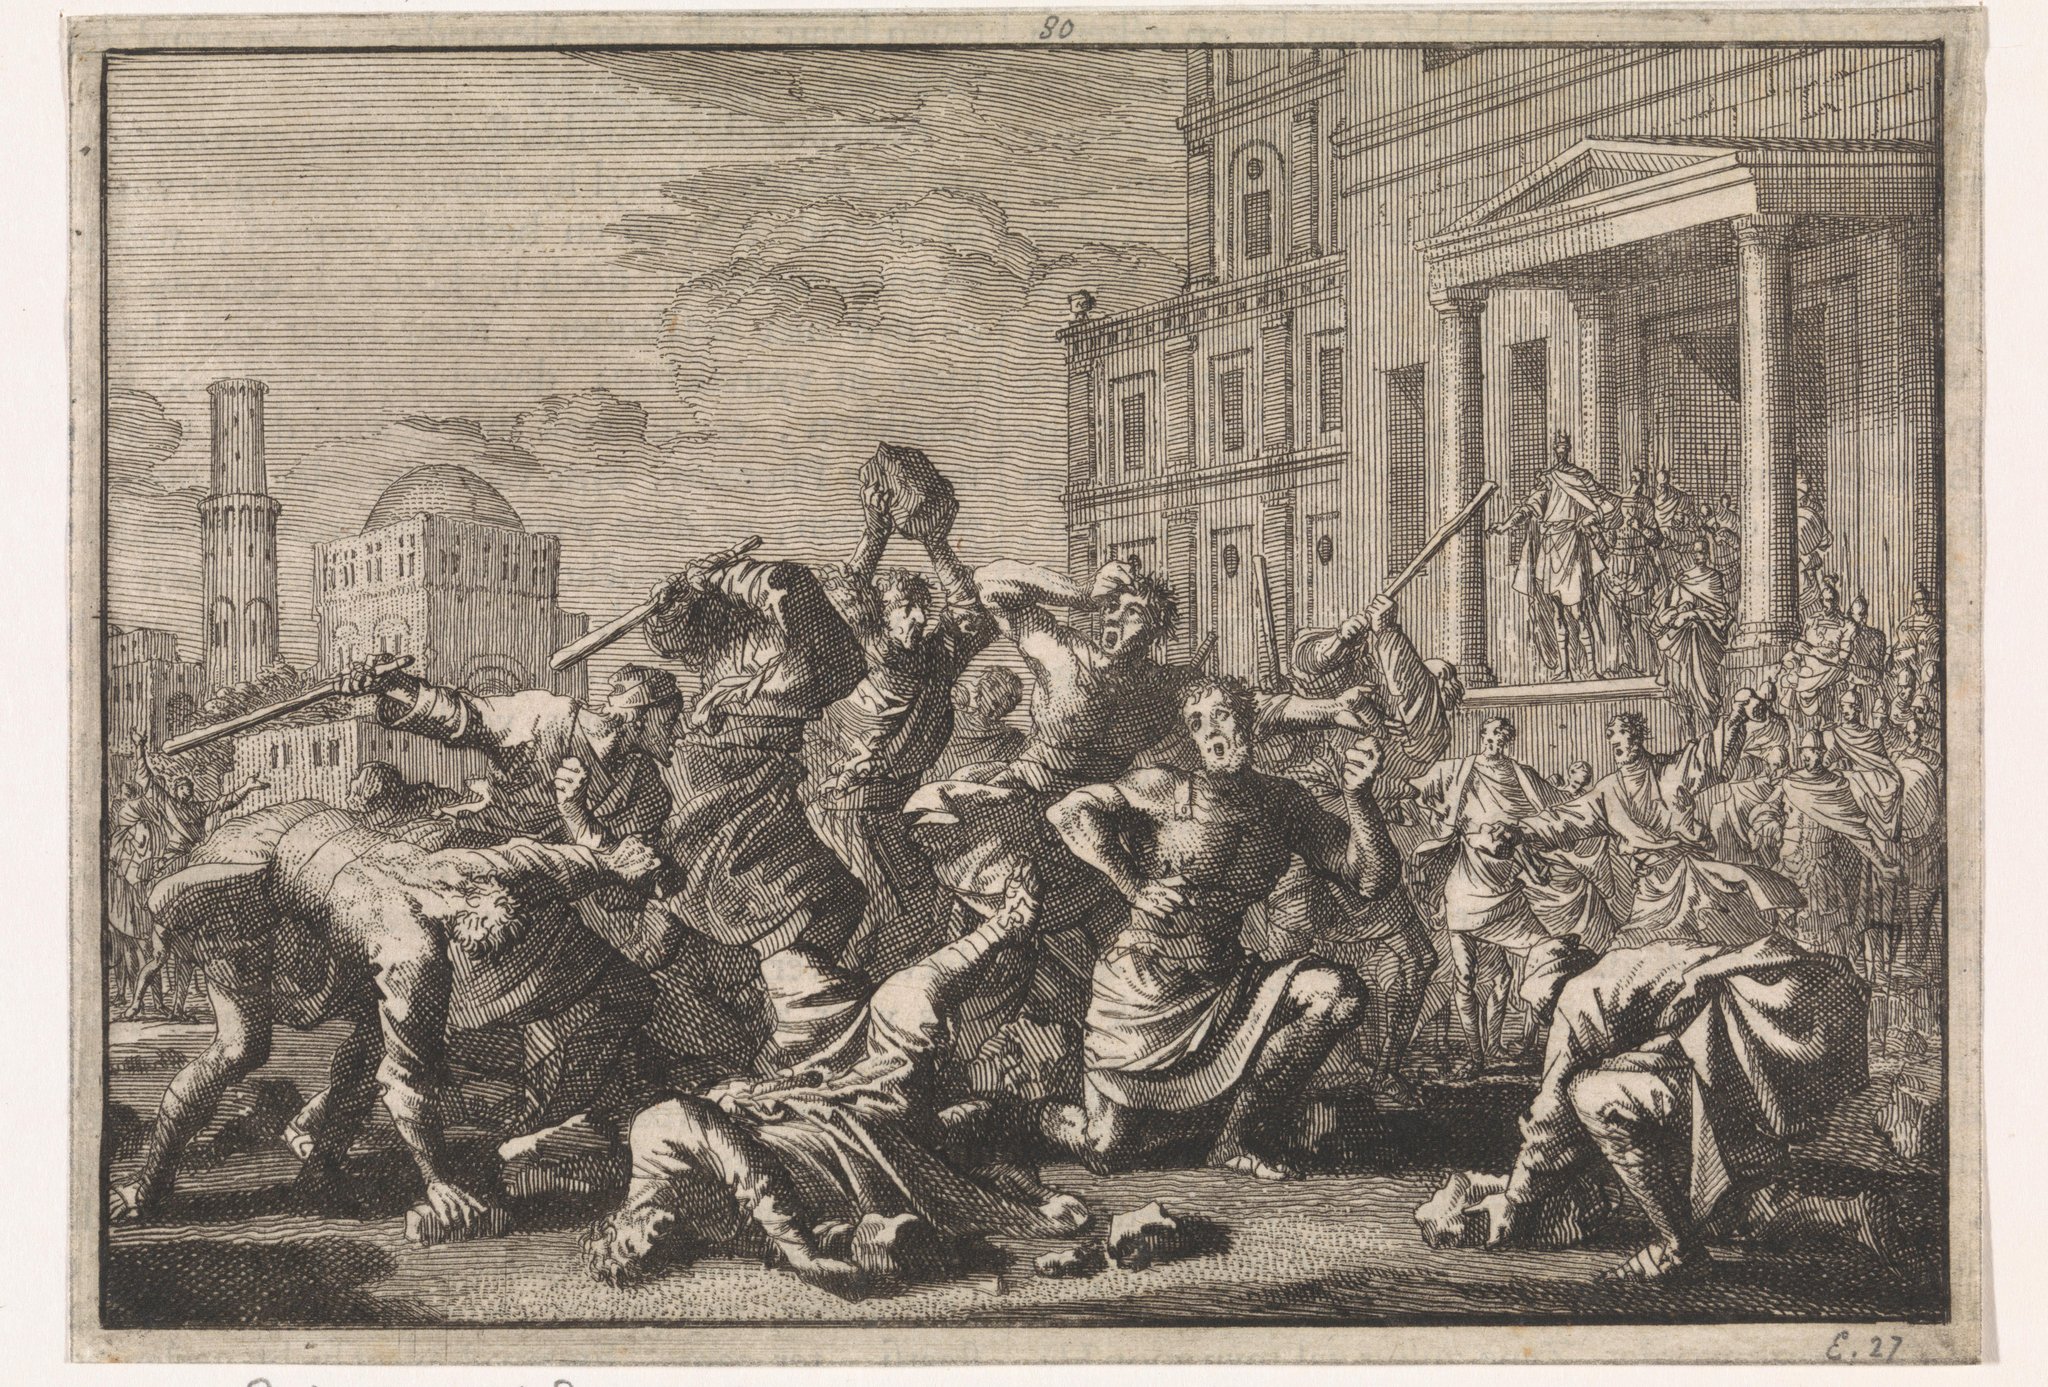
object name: book illustration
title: Herodes laat zijn barbier Tryfon, Tyro en diens zoon op verdenking van verraad stenigen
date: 1704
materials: paper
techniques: etching, letterpress printing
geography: amsterdam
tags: violent death by stoning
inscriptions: collector's mark: Lugt 2228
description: Prent opgenomen in: Josephus, Flavius. Alle de Werken, 2 delen. Amsterdam: Pieter Mortier, 1704, dl. 2, p. 27.